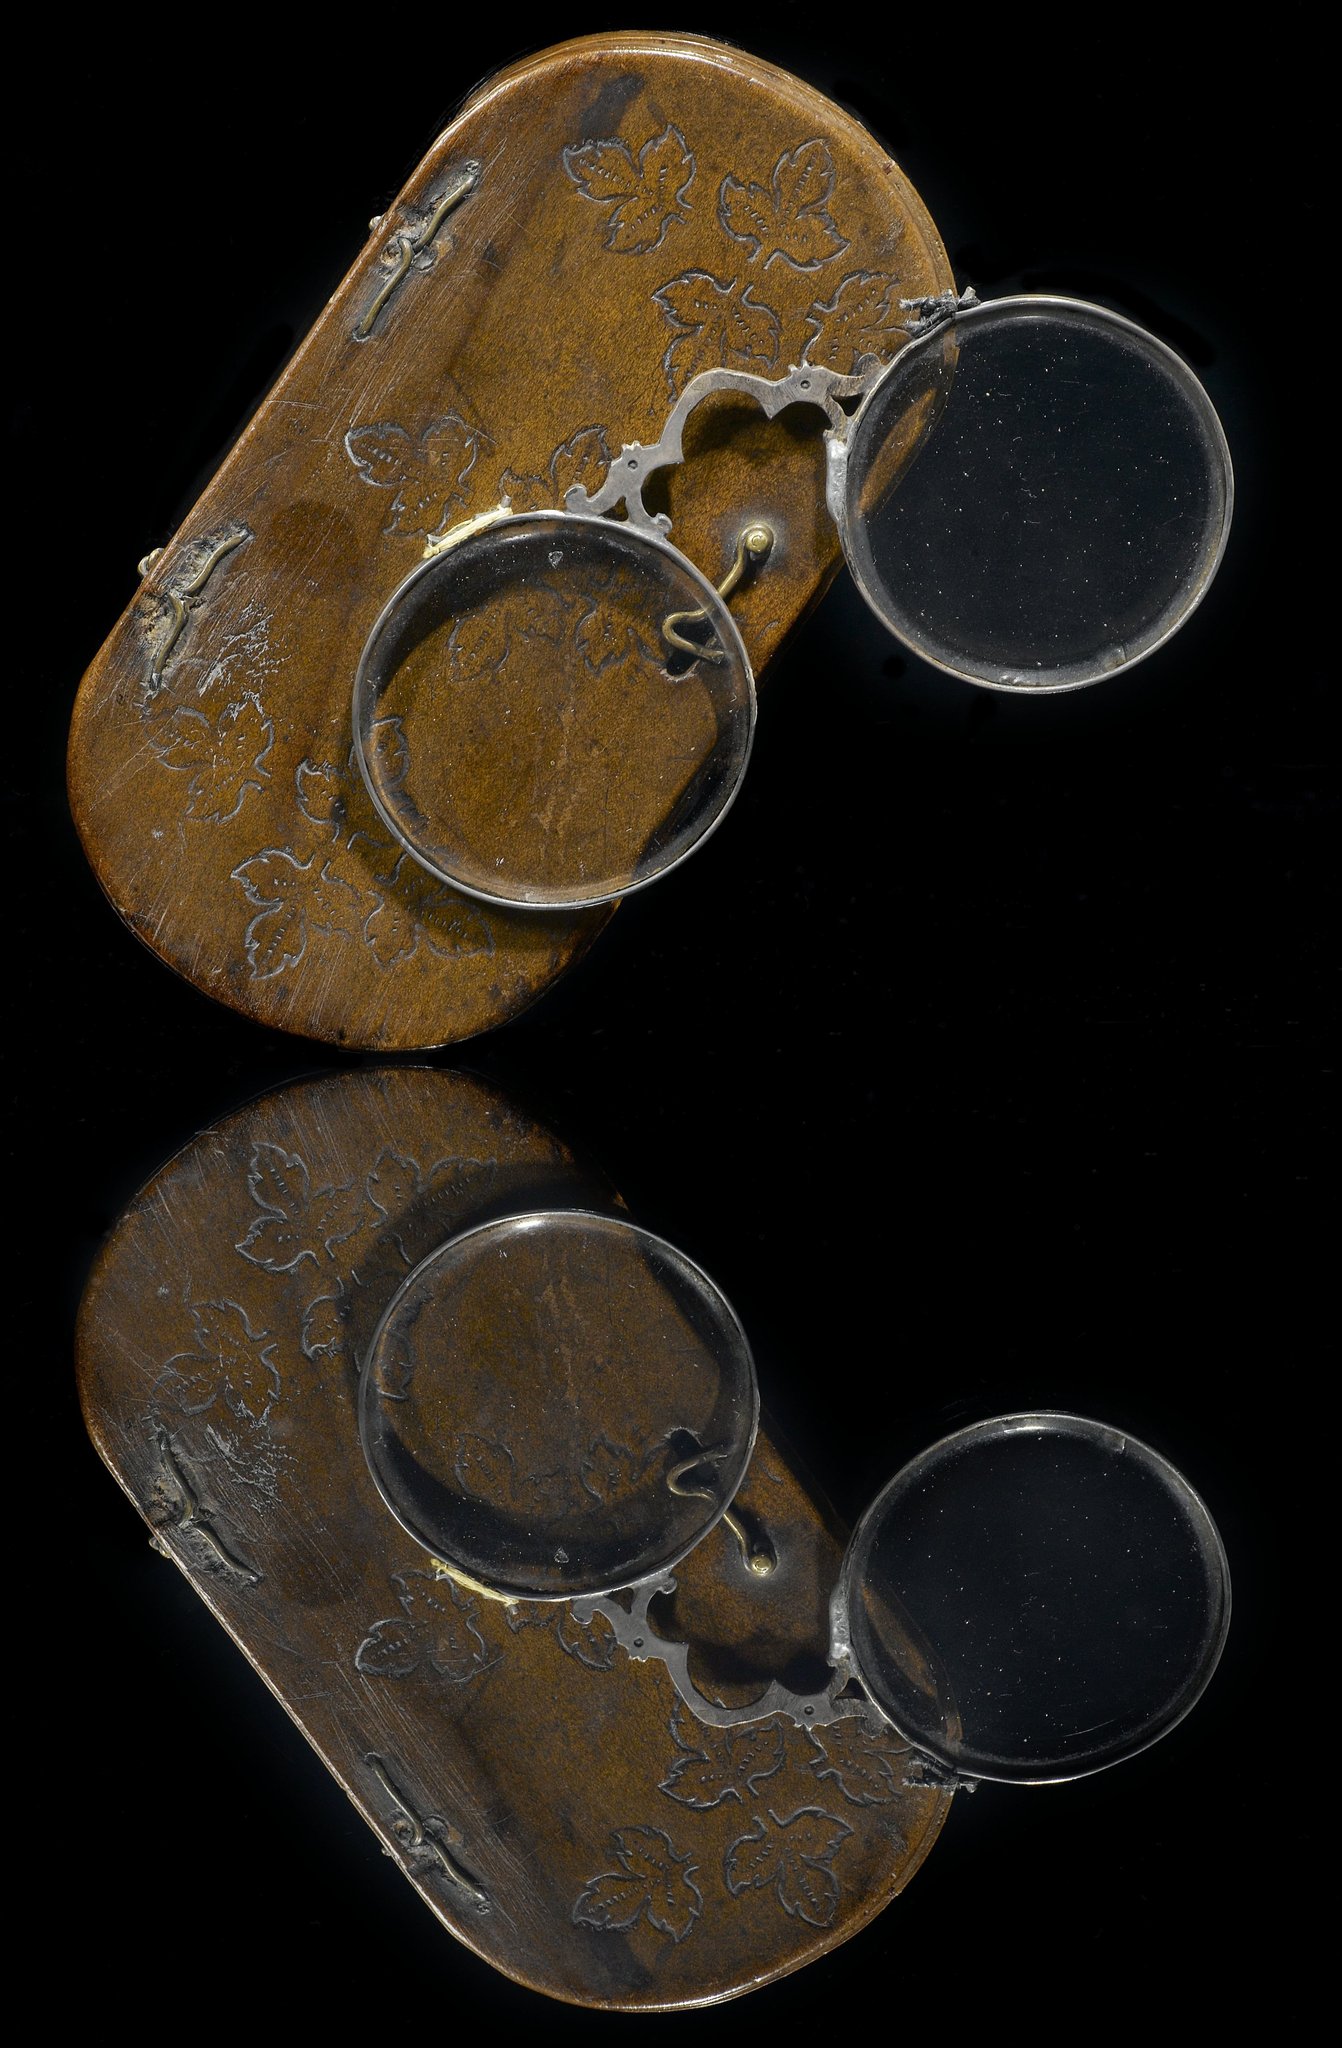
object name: brillendoos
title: Brillendoos van hout met deksel, behorend bij knijpbril van ds. A. Geesteranus (1593-1658)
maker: Anonymous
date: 1610-1658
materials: copper, wood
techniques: cutting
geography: netherlands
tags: netherlands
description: Brillendoos van hout met deksel. Model: plat met afgeronde hoeken. De doos is aan de binnenkant uitgesneden in de vorm van de knijpbrilbril en voorzien van een voering van rode stof. De deksel is aan de onderkant bevestigd door middel van twee koperen ogen die bovenop de deksel en onder de doos als splitpennen opengebogen zijn. Oorspronkelijk kwam vanuit de bodem een koperen(?) oog dat met een koperen haak gesloten werd. Het oog ontbreekt. Versiering: de deksel is versierd met ingesneden eikenbladeren die drie vierpassen vormen.